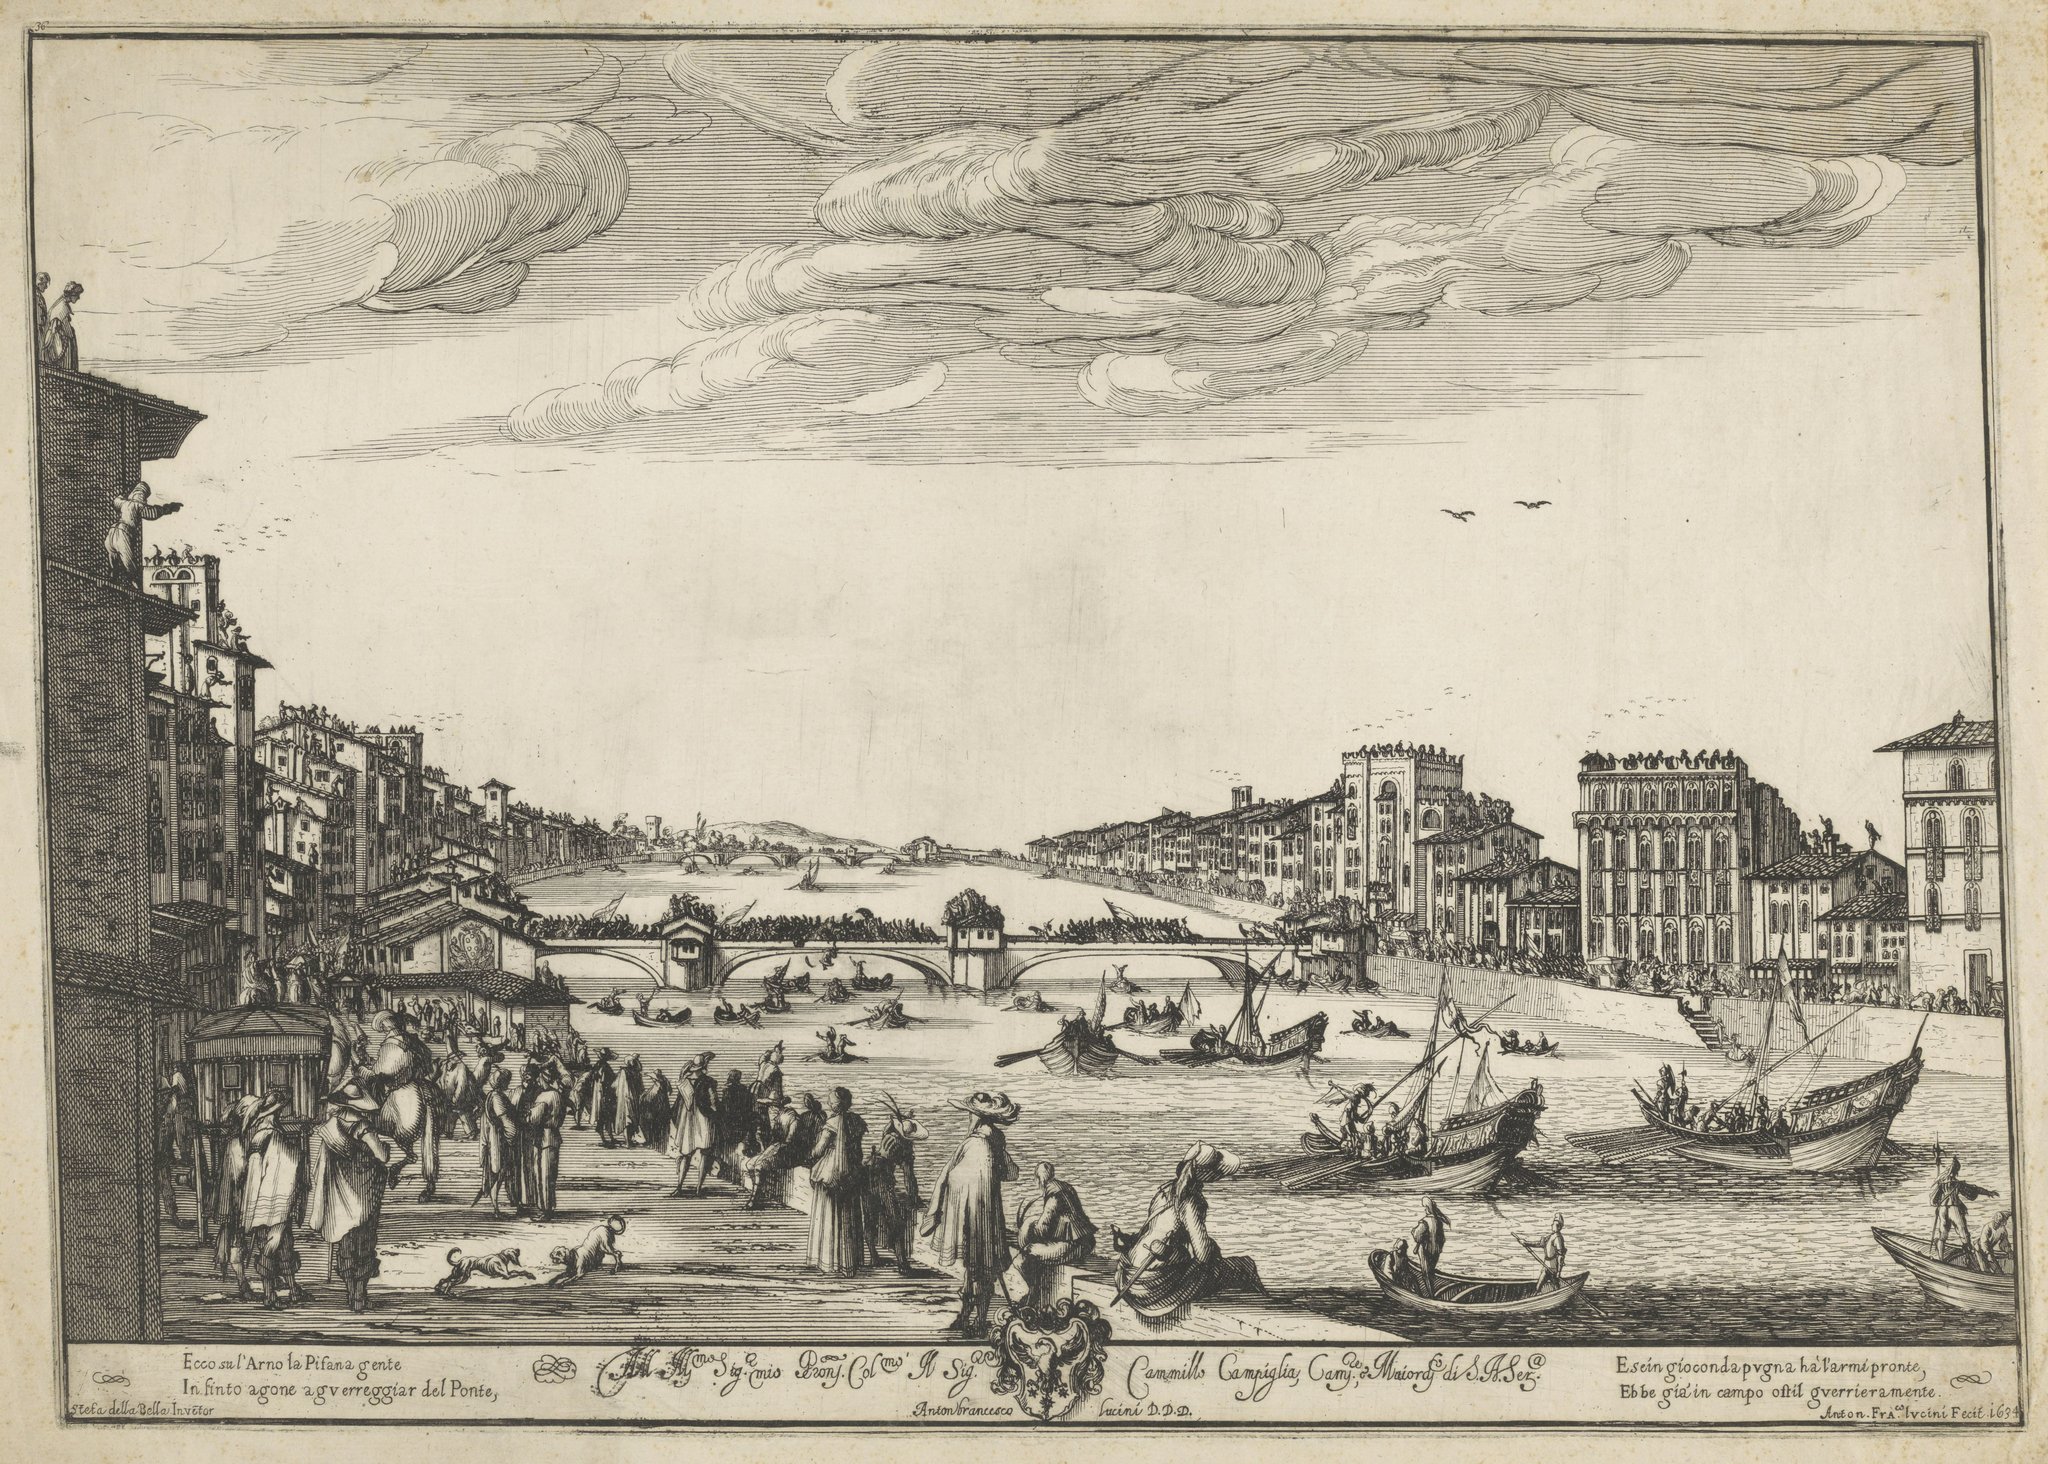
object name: print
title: Het 'Gioco del Ponte' op de Arno in Pisa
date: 1634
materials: paper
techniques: etching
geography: italy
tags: city-view, and landscape with man-made constructions, river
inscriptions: collector's mark: Lugt 240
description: Gezicht op de rivier de Arno te Pisa tijdens het 'Gioco del Ponte'. Mensen op bootjes bevaren de rivier. Toeschouwers bekijken vanaf de bruggen en kades het schouwspel. Tekst en wapenschild in ondermarge.